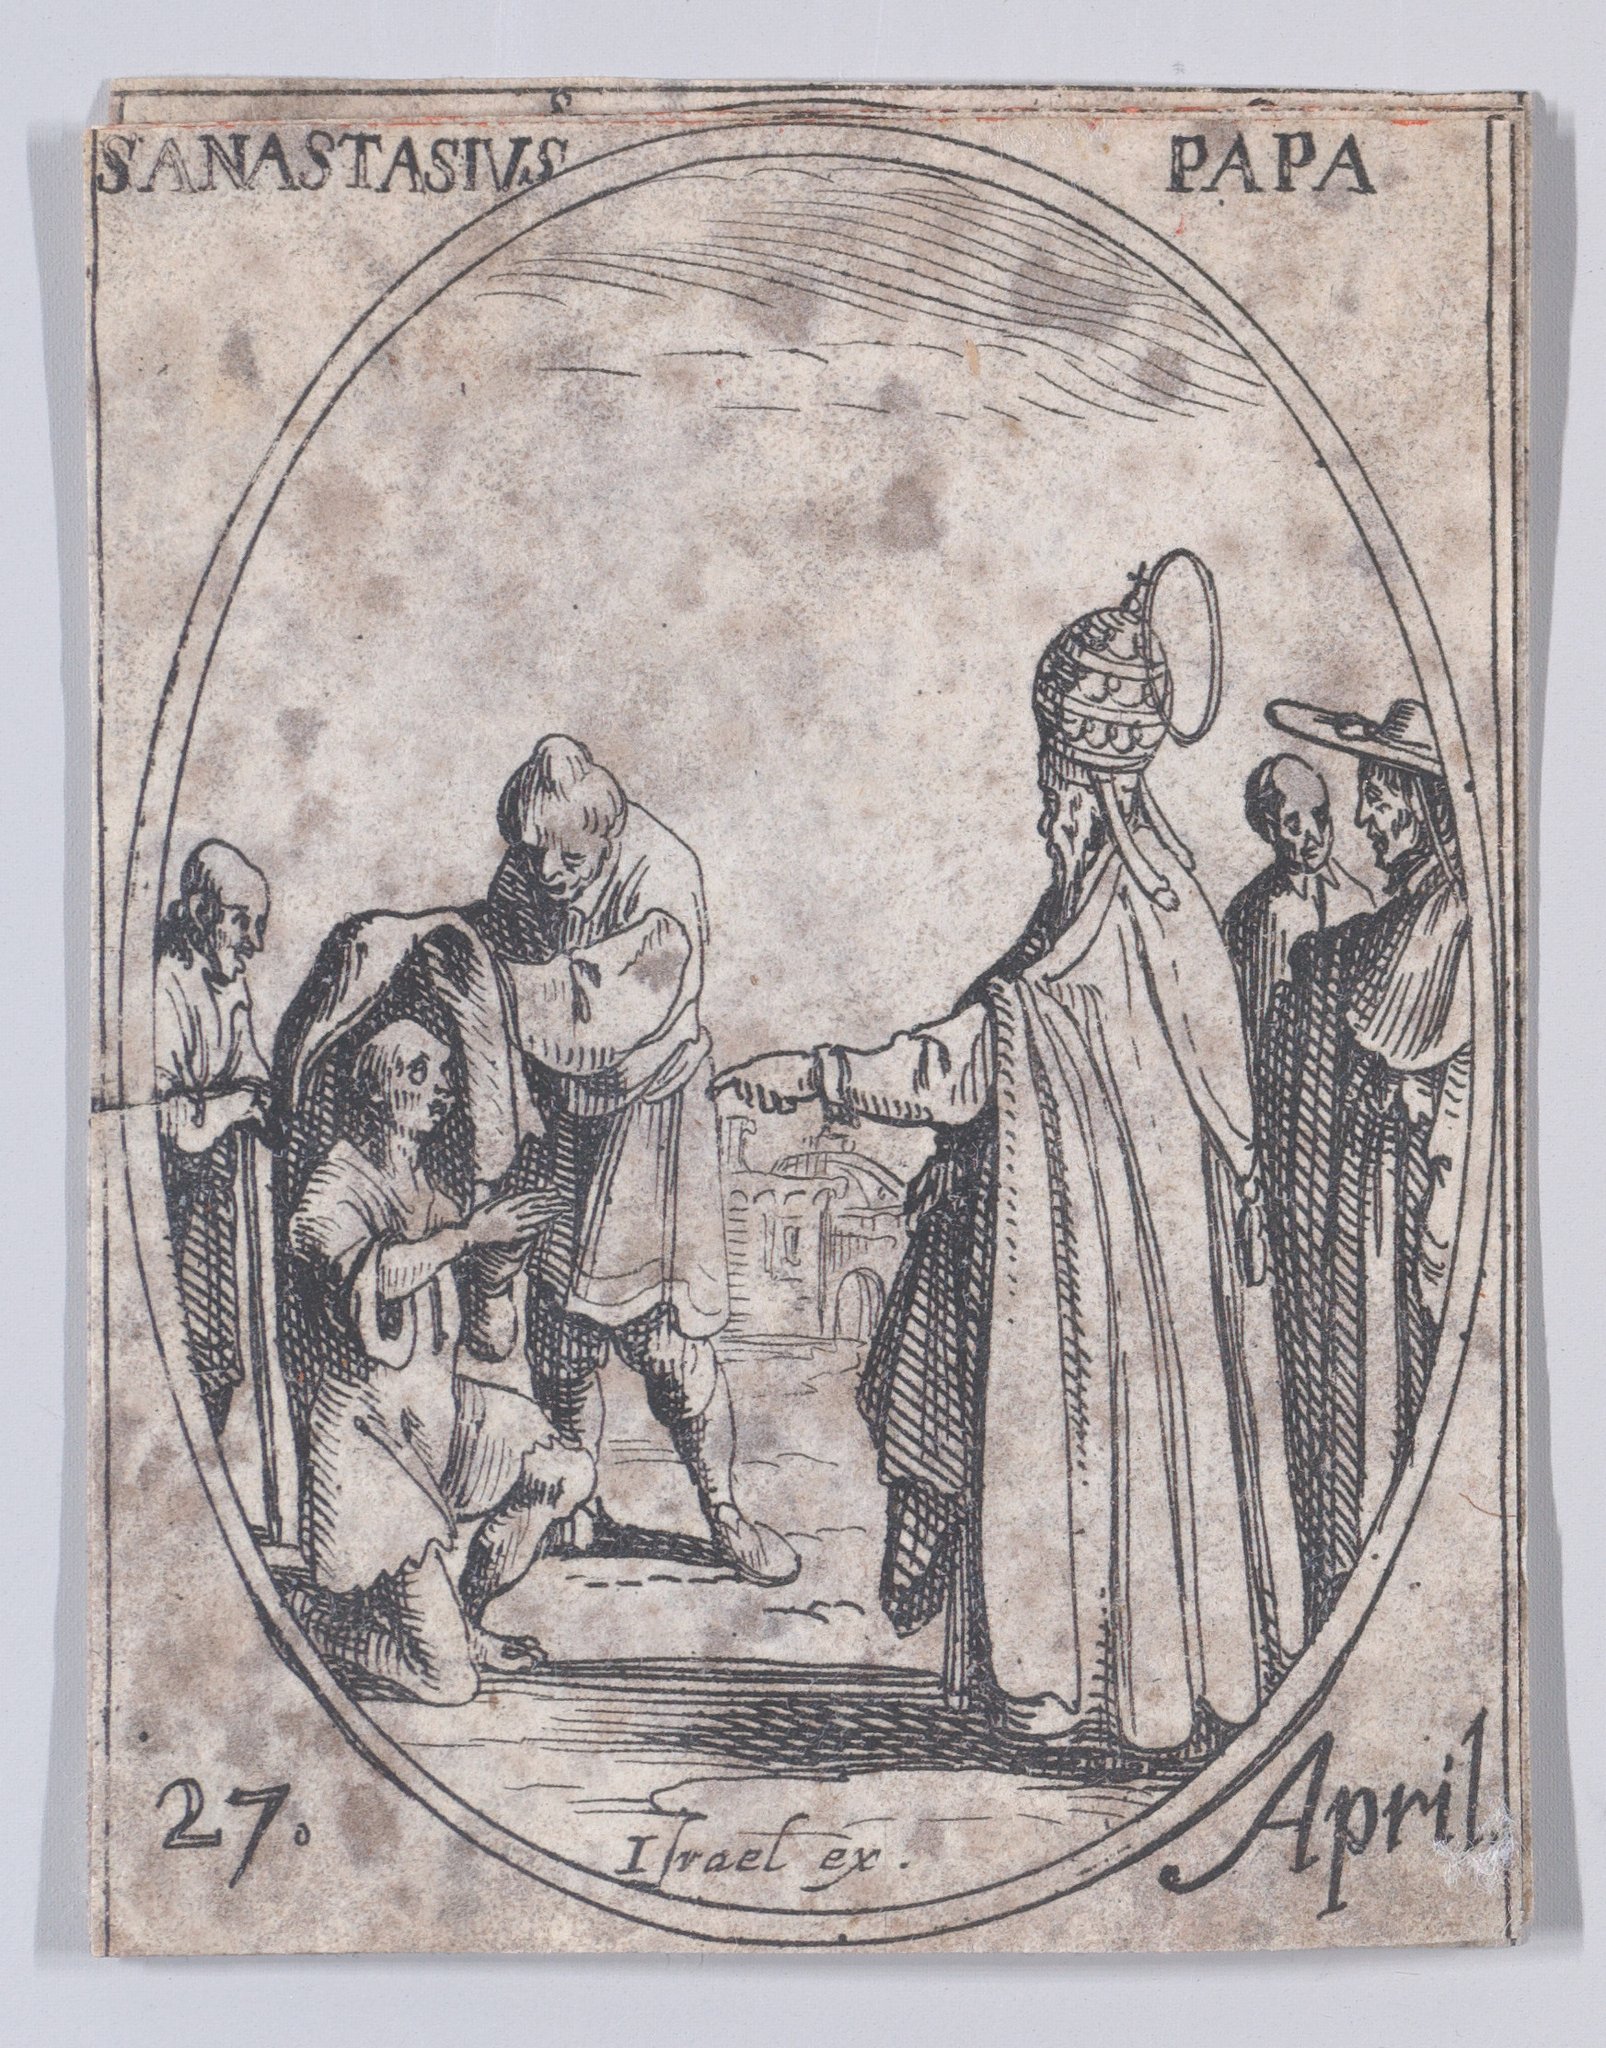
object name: print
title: S. Anastase, pape (St. Anastasius, Pope), April 27th, from "Les Images De Tous Les Saincts et Saintes de L'Année" (Images of All of the Saints and Religious Events of the Year)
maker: jacques callot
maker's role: artist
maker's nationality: french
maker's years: 1592-1635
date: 1636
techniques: etching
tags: men,saints